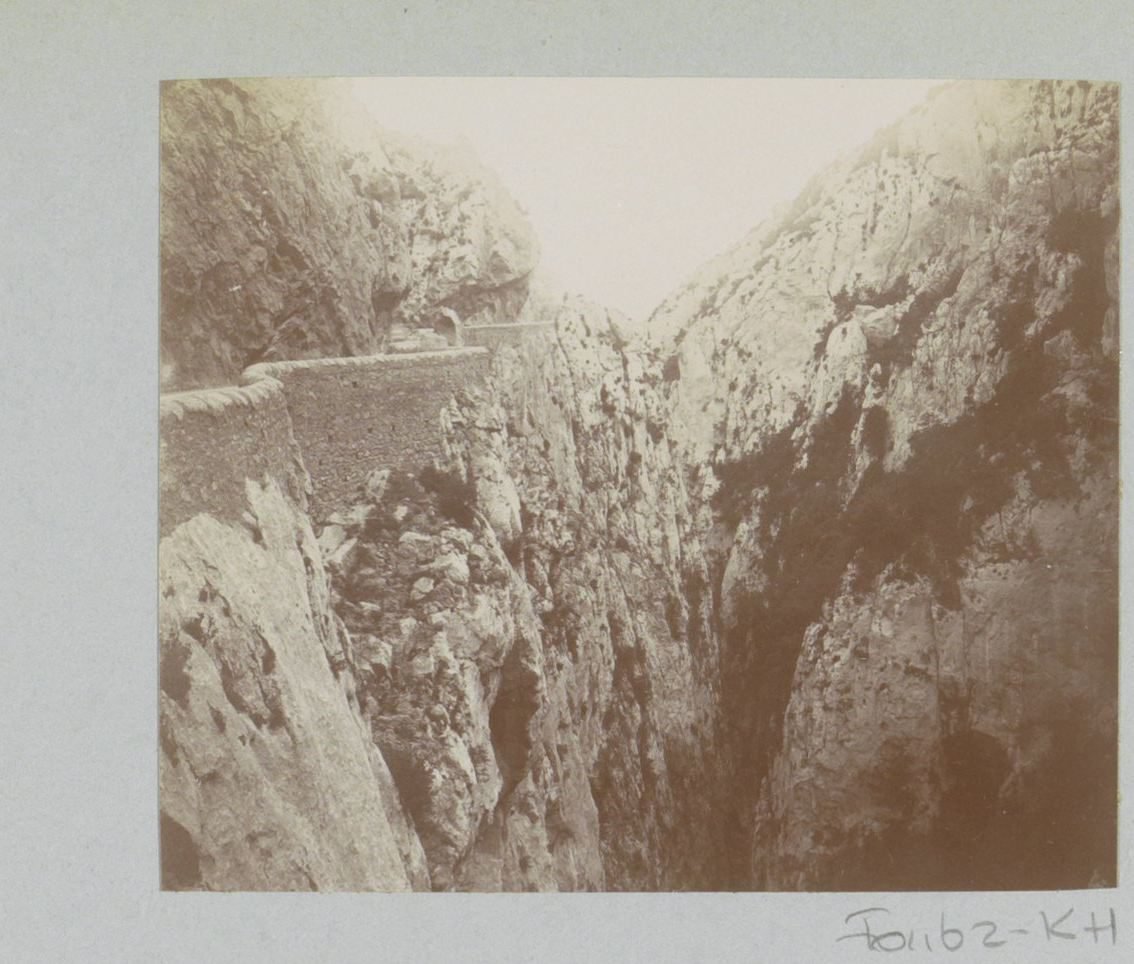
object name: photograph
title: Gezicht op een kloof, vermoedelijk in de Pyreneeën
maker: Anonymous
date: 1905-1910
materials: paper, photographic support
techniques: gelatin silver print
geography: pyrenees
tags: ravine, chasm, abyss, canyon, mountains (+ landscape with figures, staffage)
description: Onderdeel van Fotoalbum van een Franse amateurfotograaf met bezienswaardigheden in Frankrijk, Zwitserland en Italië.